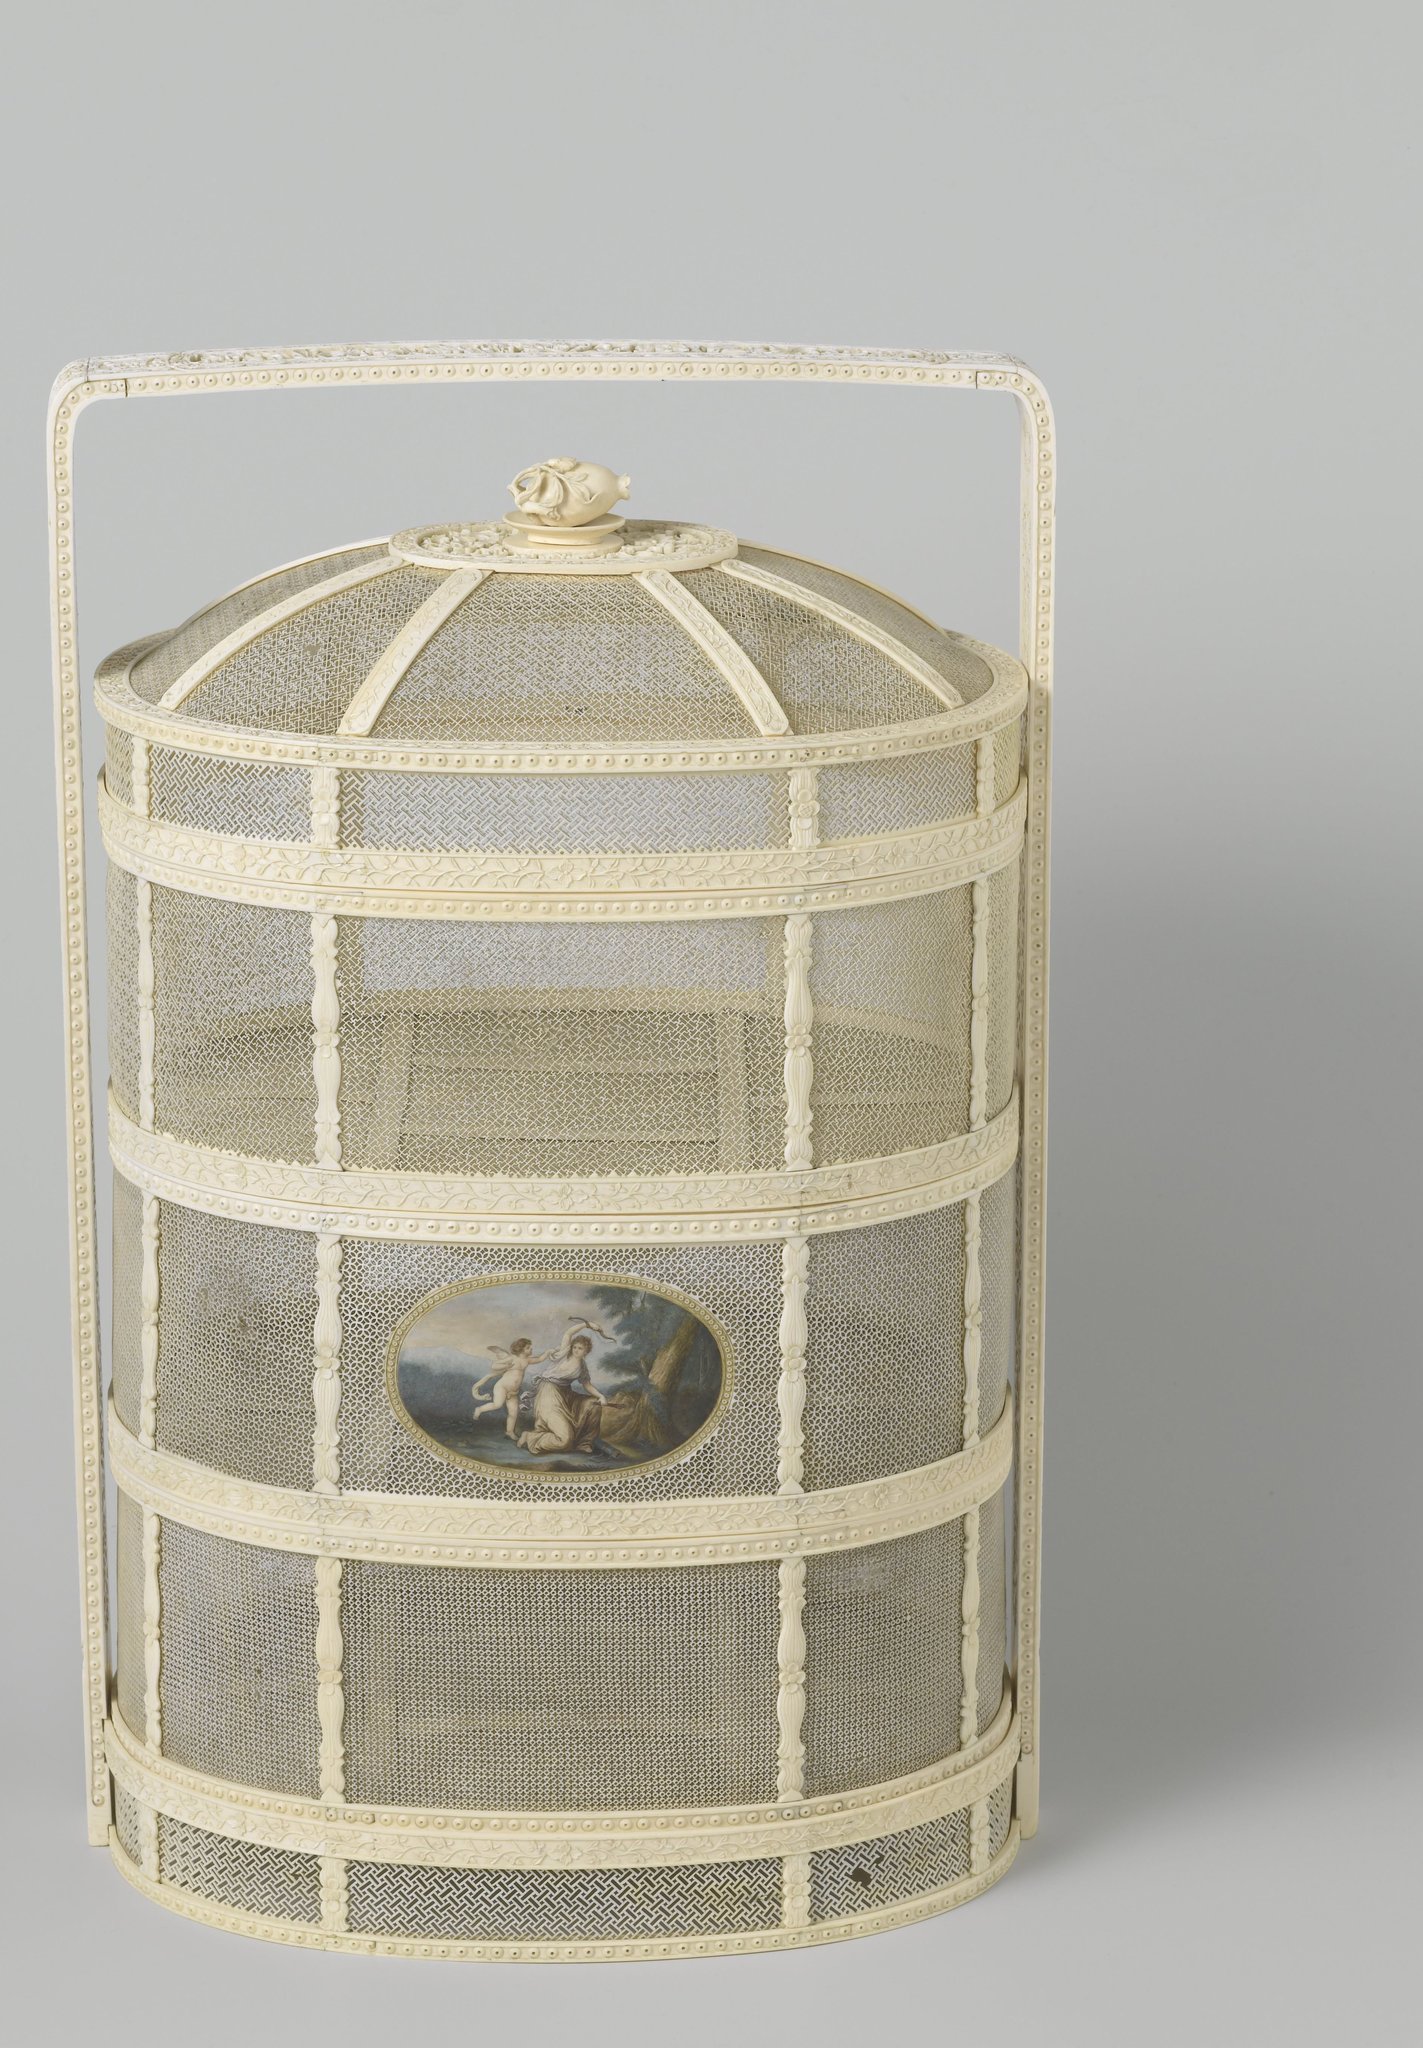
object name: stapeldoos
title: Stacking Basket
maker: Anonymous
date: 1795-1810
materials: ivory, paint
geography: guangdong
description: The shape of this decorative object is derived from a stacking box for meals, comprising three trays one atop the other and a handle. Crafted from intricate openwork ivory, all of the sides have different decorative patterns. The medallions frame paintings after the work of Angelica Kauffmann, a highly esteemed German painter of this period.